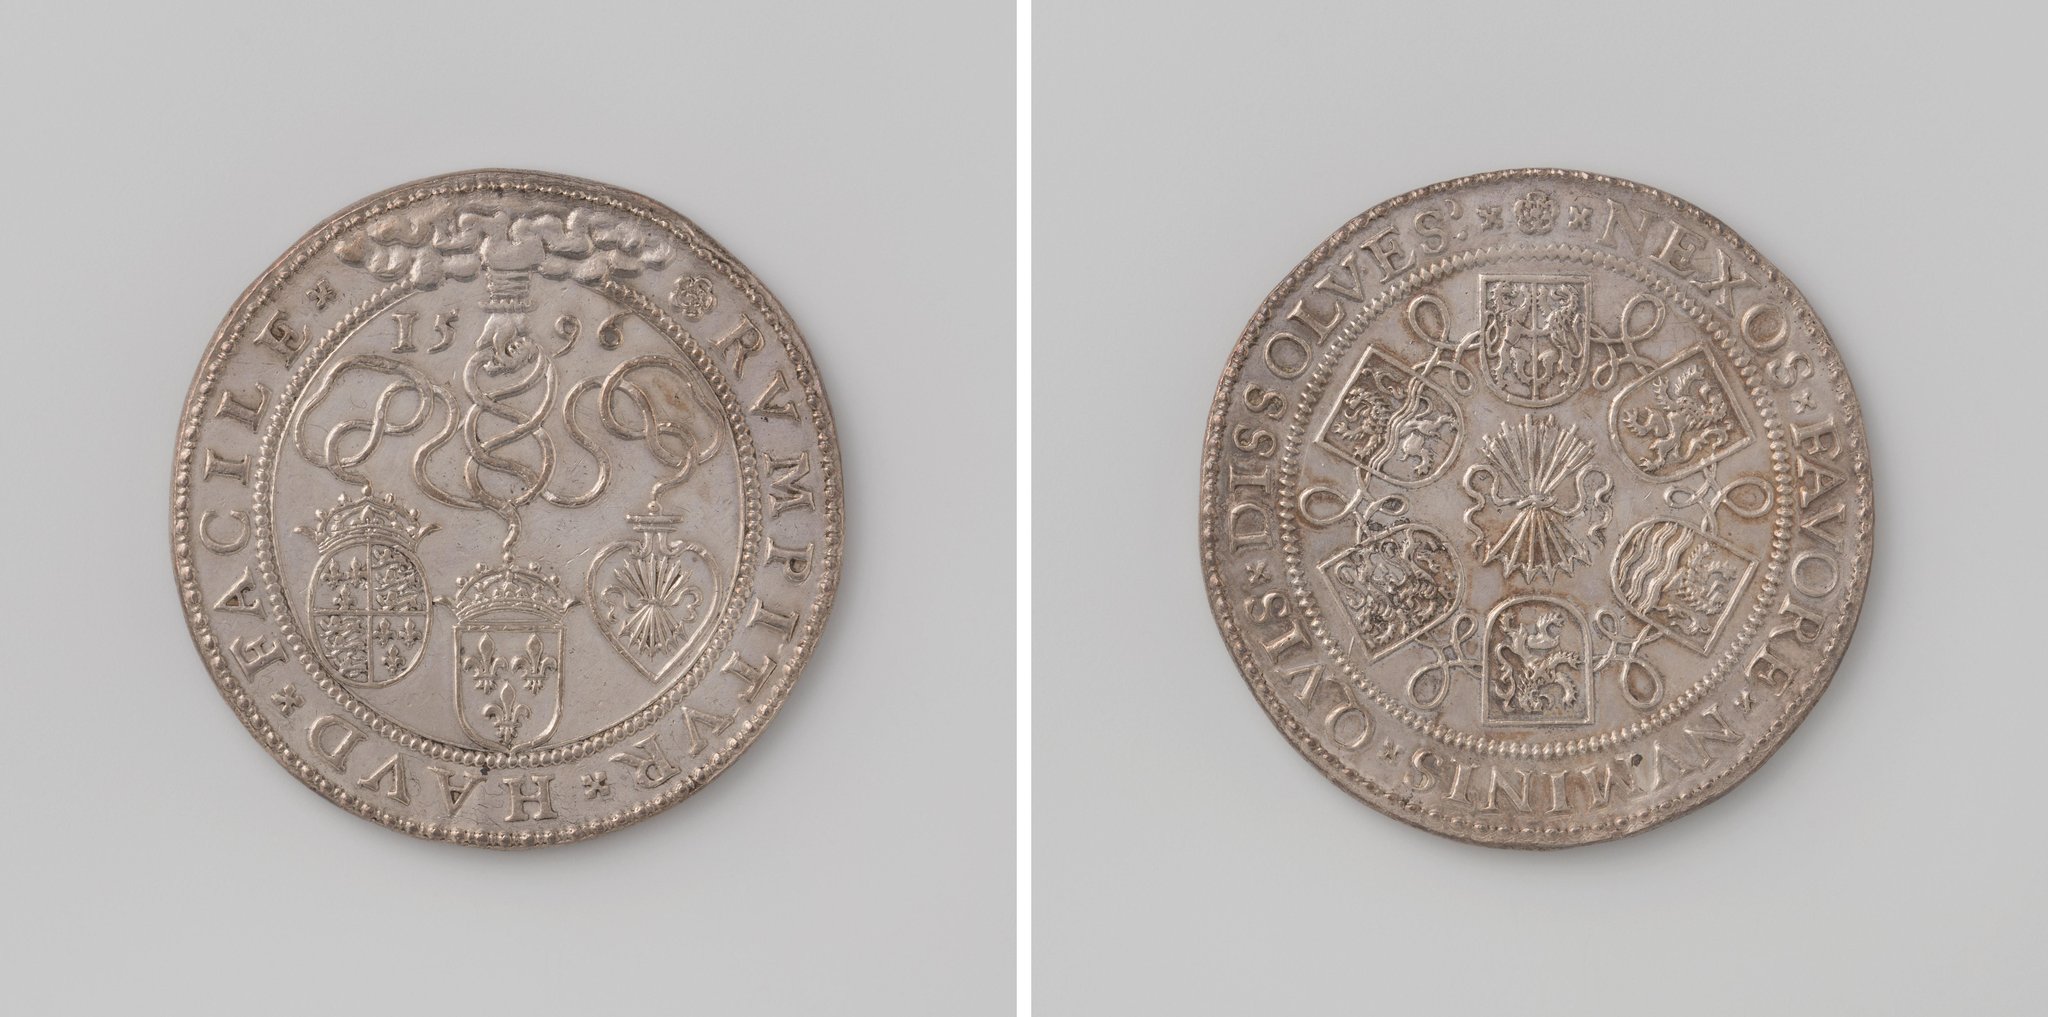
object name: triomfpenning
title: Het drievoudige verbond tussen Engeland, Frankrijk en de Republiek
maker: gerard van bylaer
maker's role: die cutter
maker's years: 1540-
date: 1596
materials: silver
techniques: striking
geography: dordrecht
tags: netherlands, france, england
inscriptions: circumscription: ‘NEXOS FAVORE NVMINIS QVIS DISSOLVES’, circumscription: ‘RVMPITVR HAVD FACILE / 1596’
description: Zilveren penning. Voorzijde: hand uit wolken houdt drie met lint verbonden wapenschilden vast binnen omschrift. Keerzijde: zes met lint verbonden wapenschilden rondom pijlenbundel binnen omschrift.